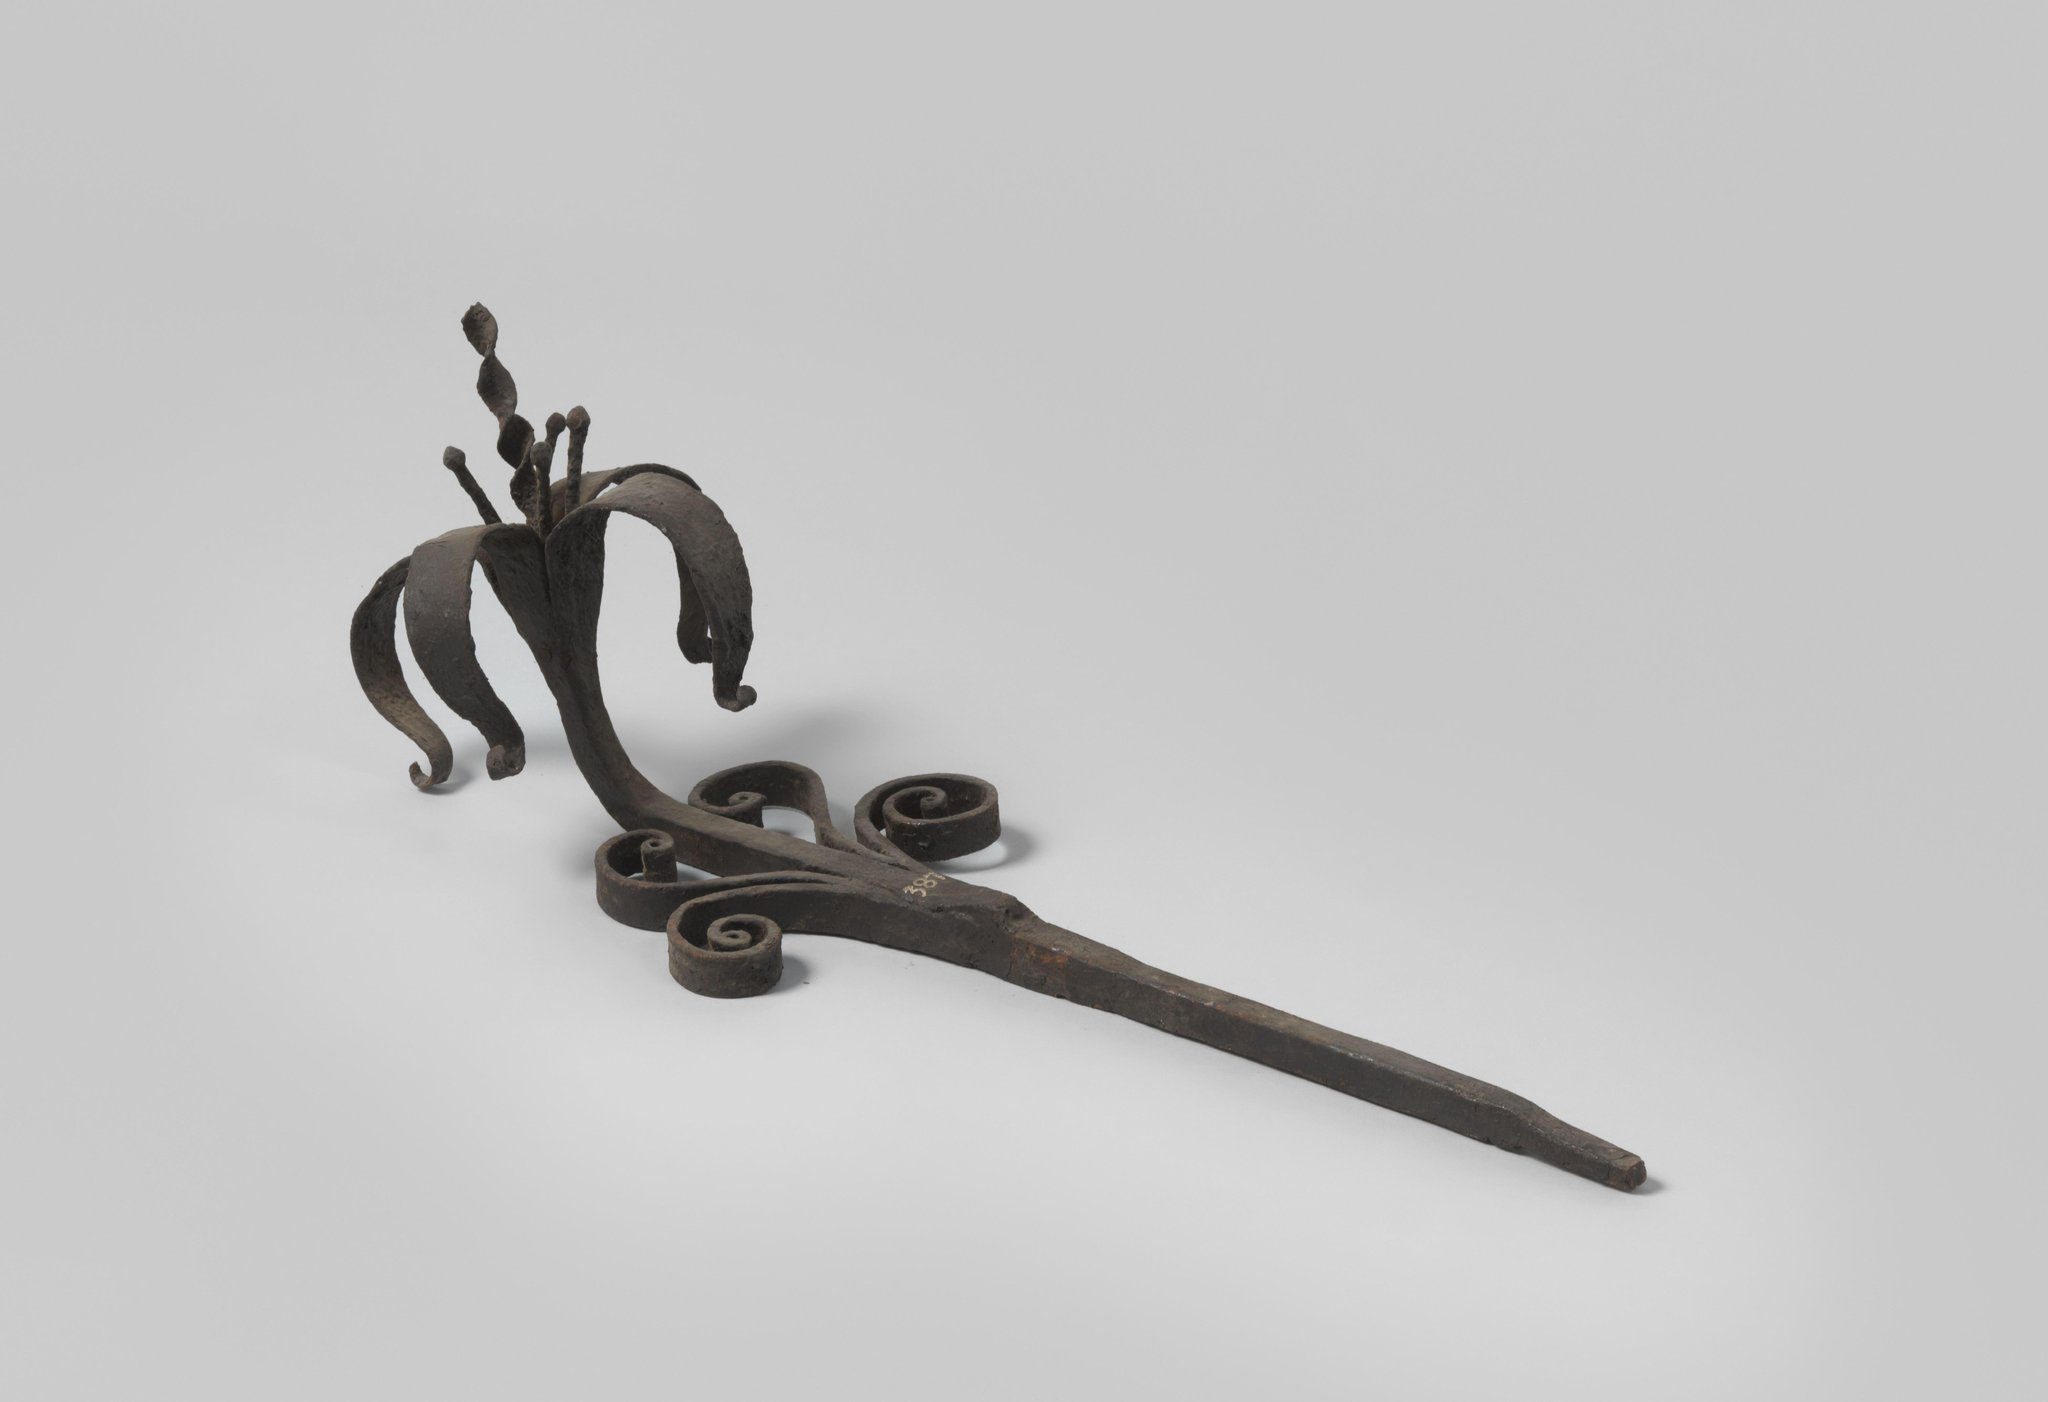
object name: schieter, schoter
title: Muuranker, waarvan de schieter uitloopt in een gebogen lelie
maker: Anonymous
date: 1620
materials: iron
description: Muuranker, bestaande uit veer en schieter. De schieter loopt uit in een gebogen lelie. Afkomstig uit Zwartsluis.